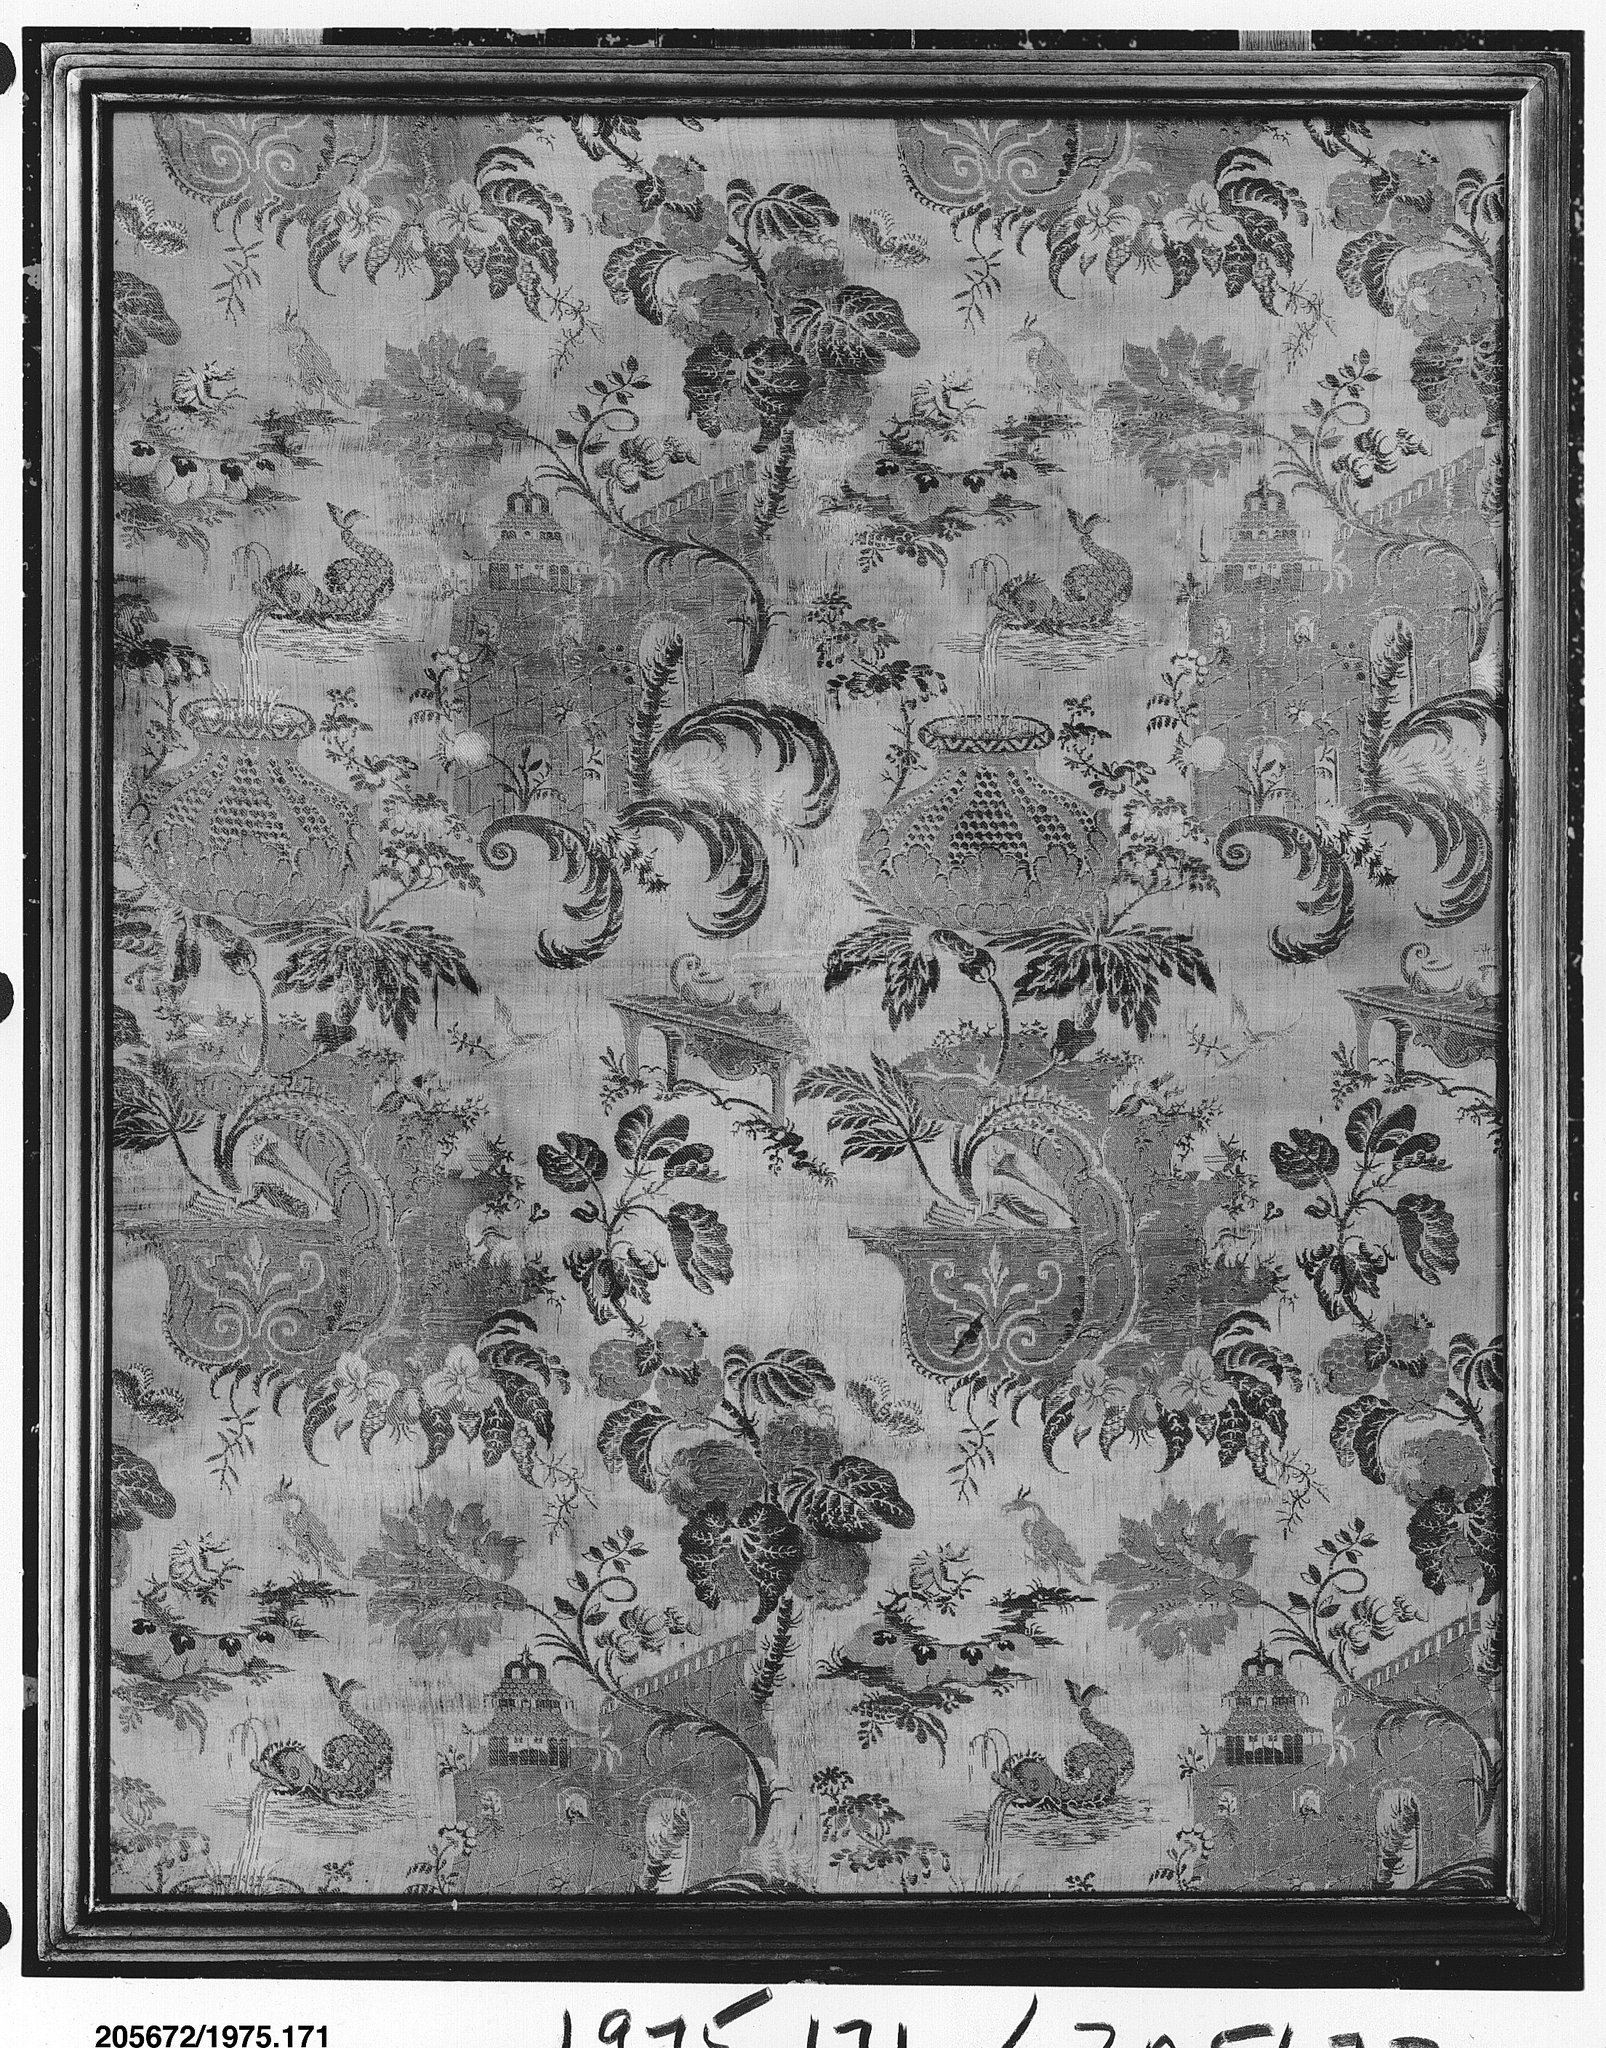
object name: panel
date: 1740-1749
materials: metal thread, silk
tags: birds,fountains,fish,flowers